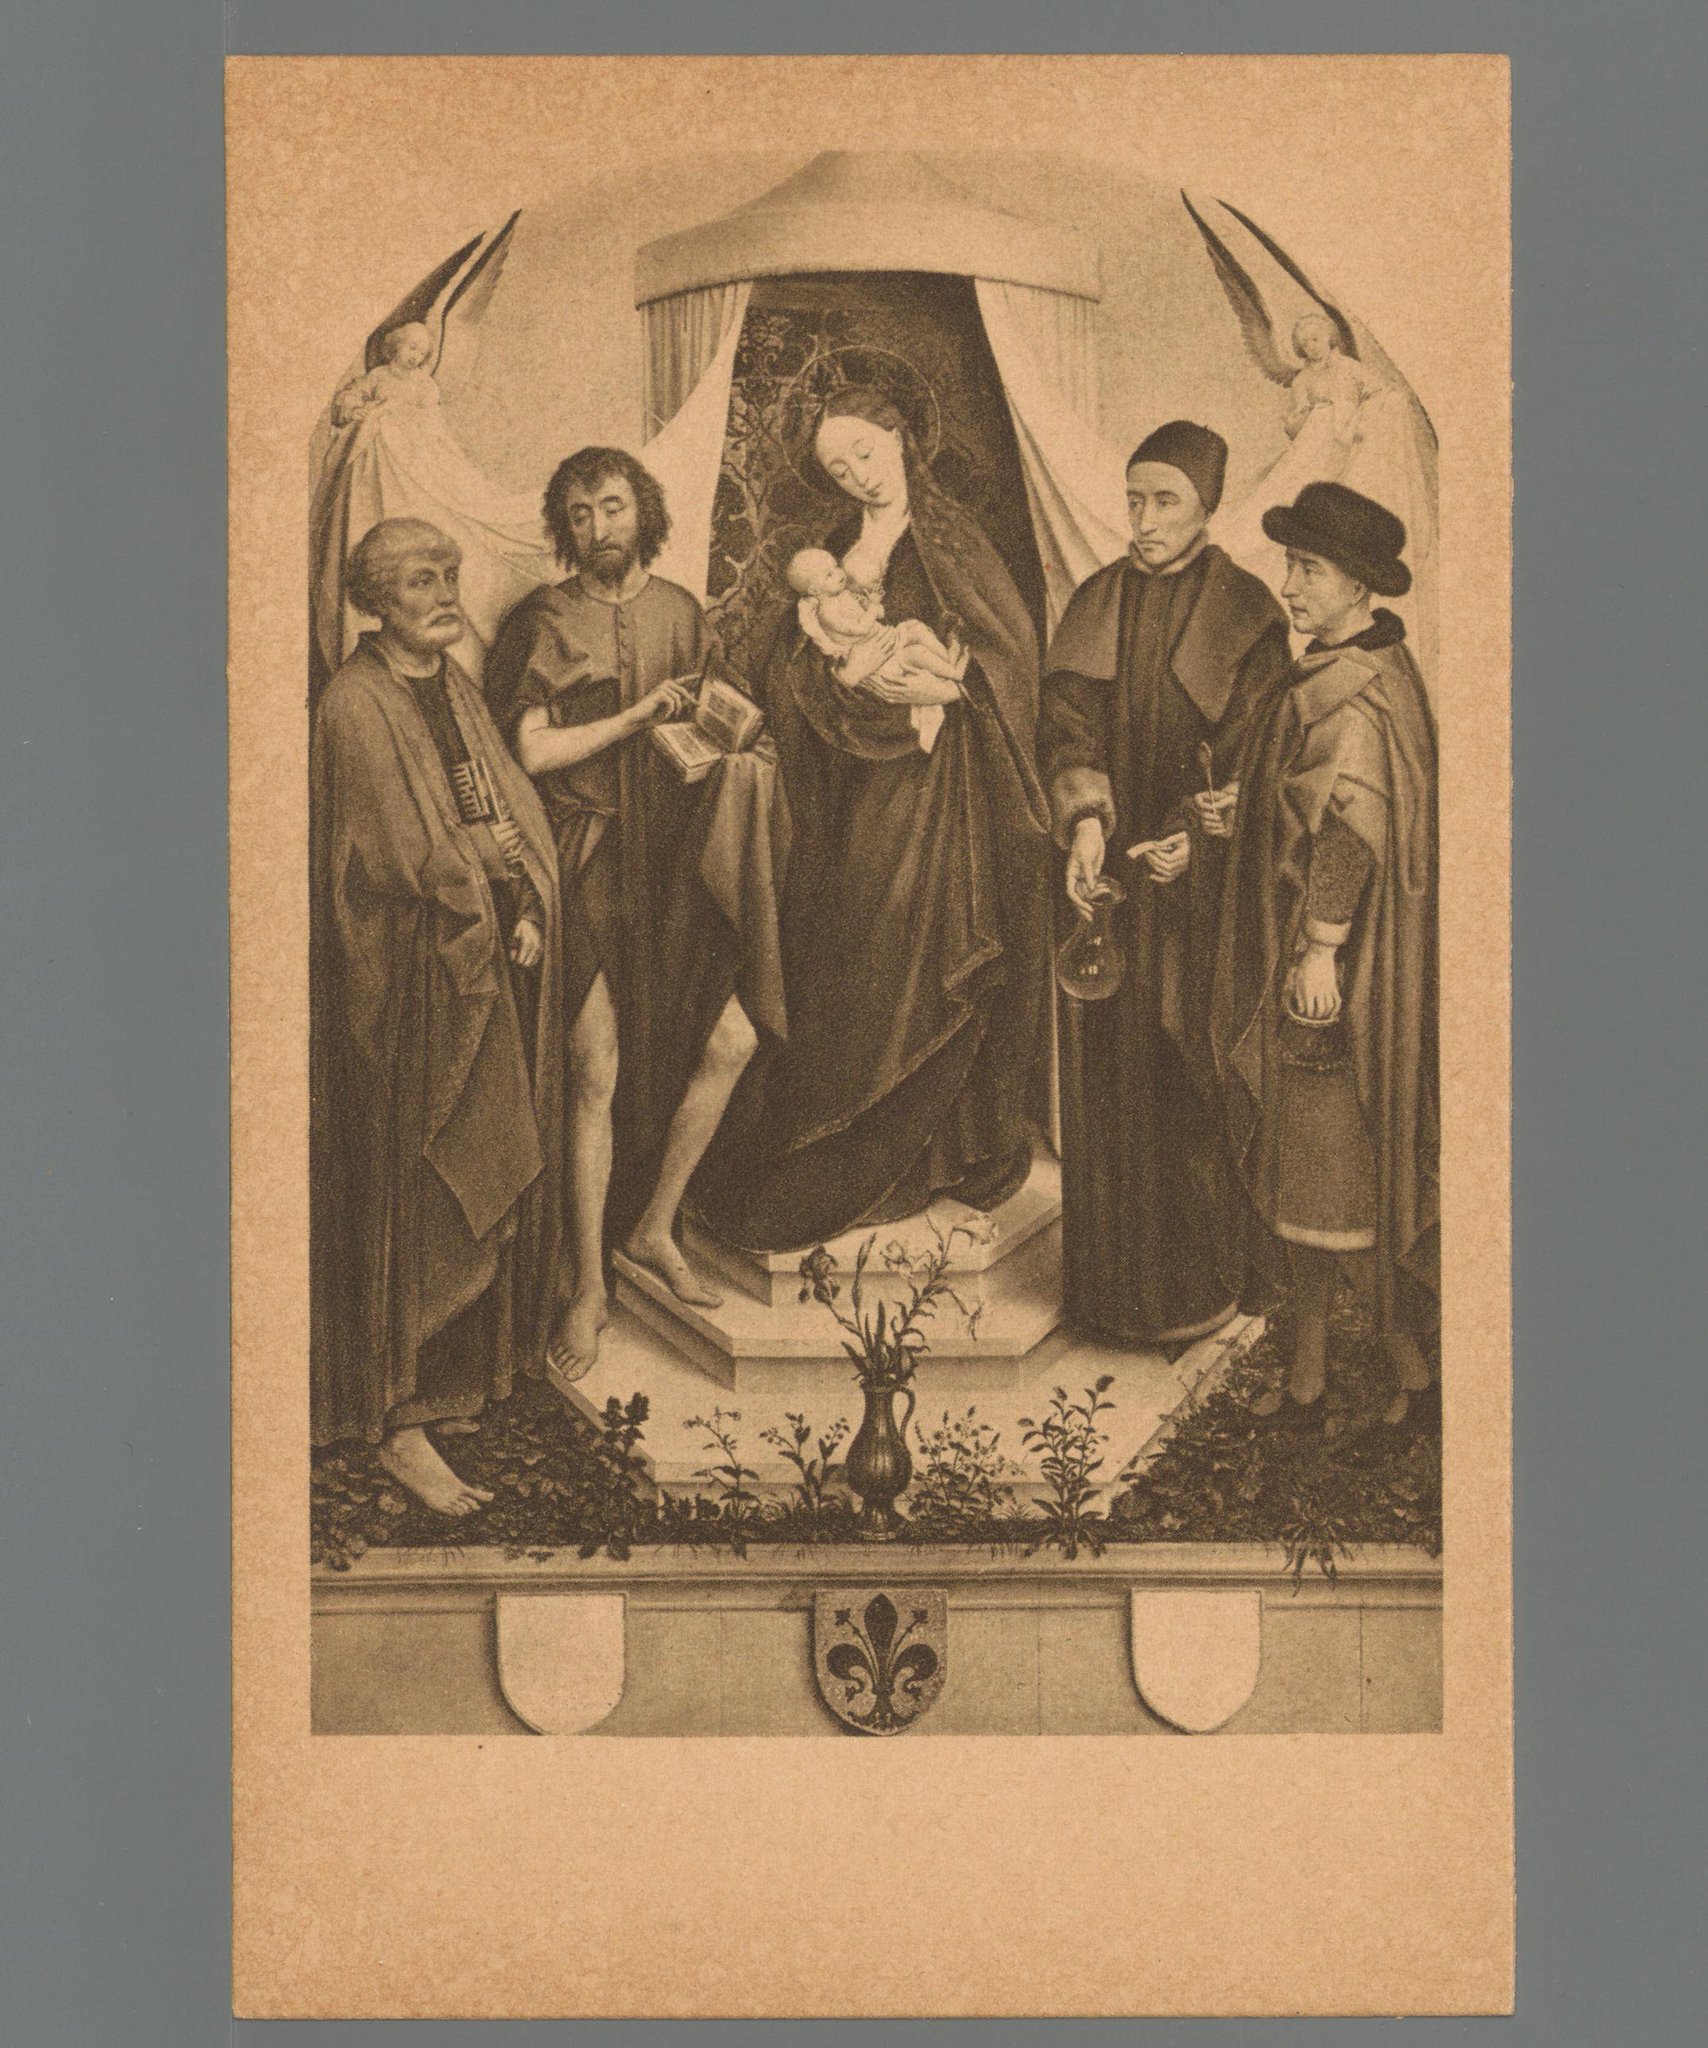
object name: ansichtkaart, prentbriefkaart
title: Roger van der Weyden: Maria mit dem Kinde und die hl. Petrus, Johannes d. T., Cosmas u. Damian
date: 1905-1930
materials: cardboard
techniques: rotogravure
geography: frankfurt am main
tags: permanent exhibition, museum, picture, painting